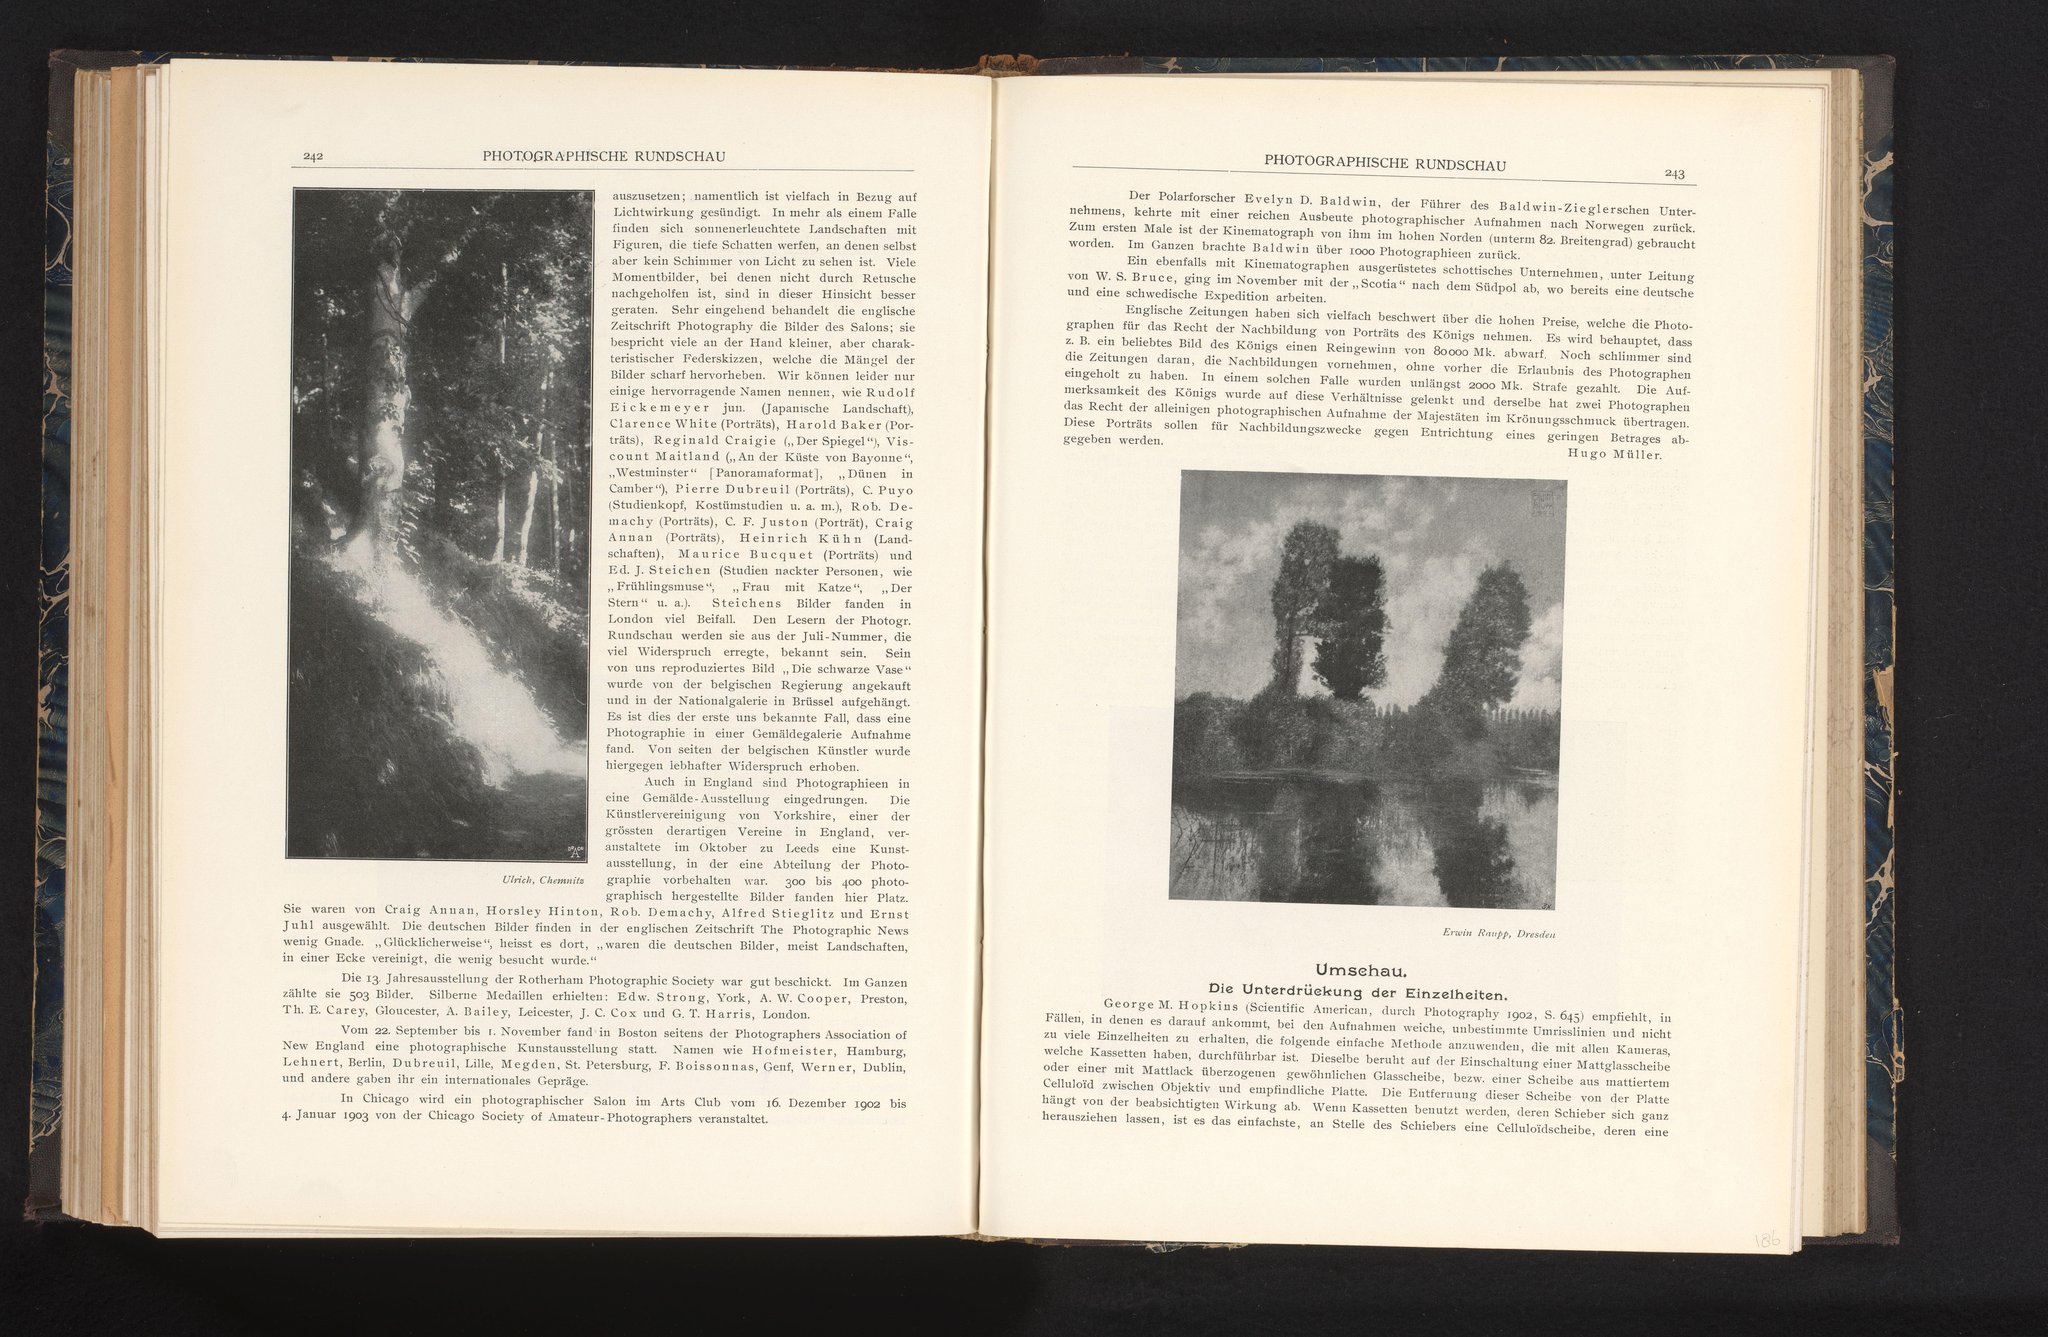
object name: page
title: Gezicht op bomen aan een water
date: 1897-1902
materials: paper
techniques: autotype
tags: trees, landscapes with waters, waterscapes, seascapes (in the temperate zone)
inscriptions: monogram: ‘BX’